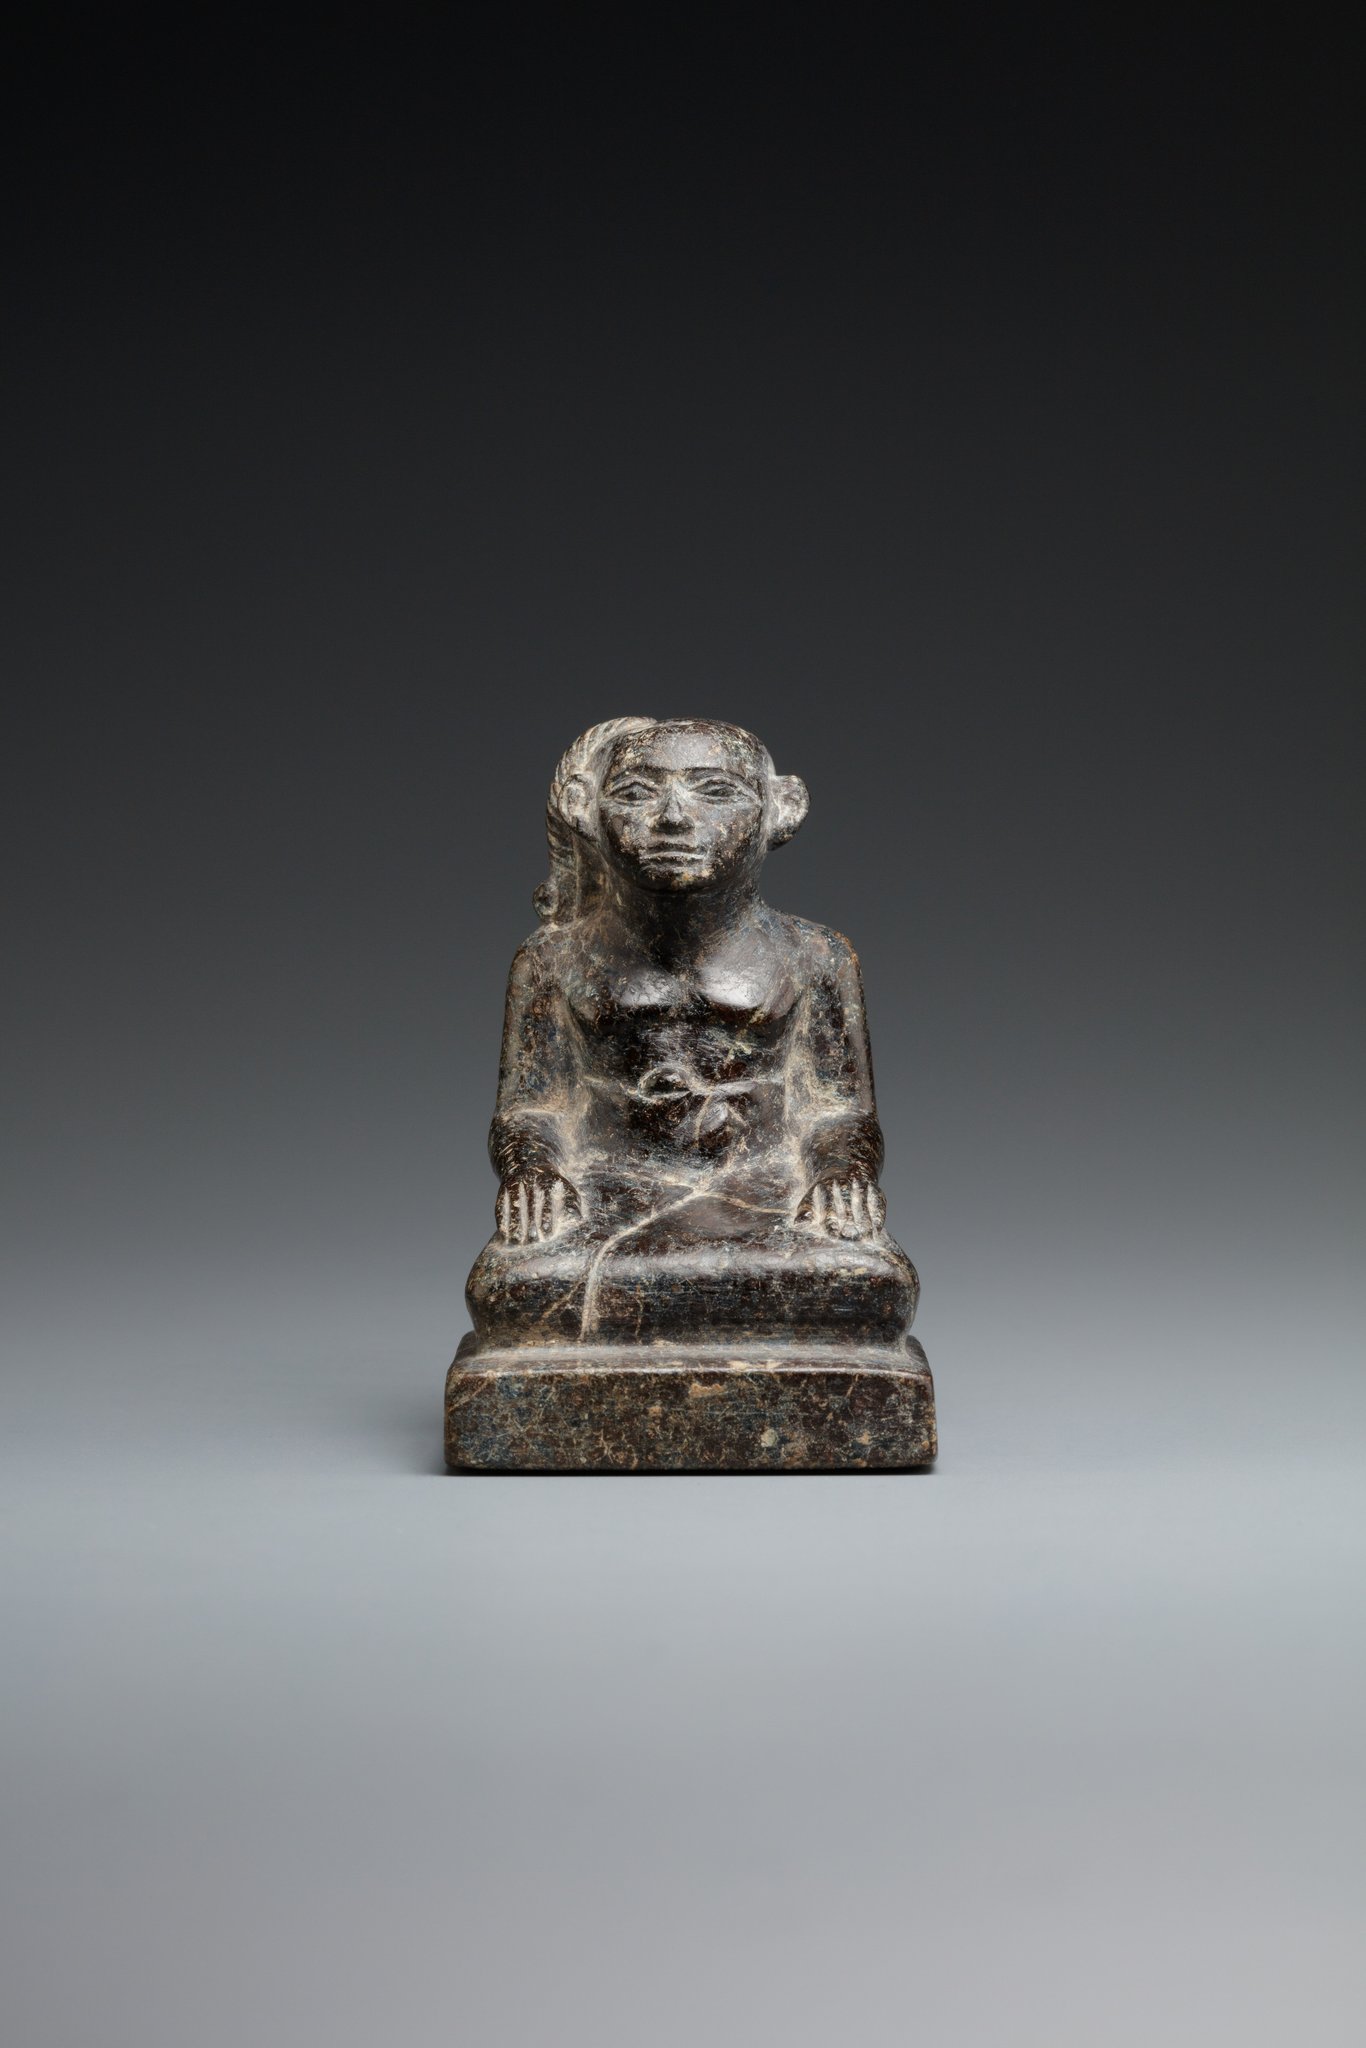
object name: statuette, male with sidelock of youth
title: Statuette of male youth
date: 1850-1775 BCE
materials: stone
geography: egypt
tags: men